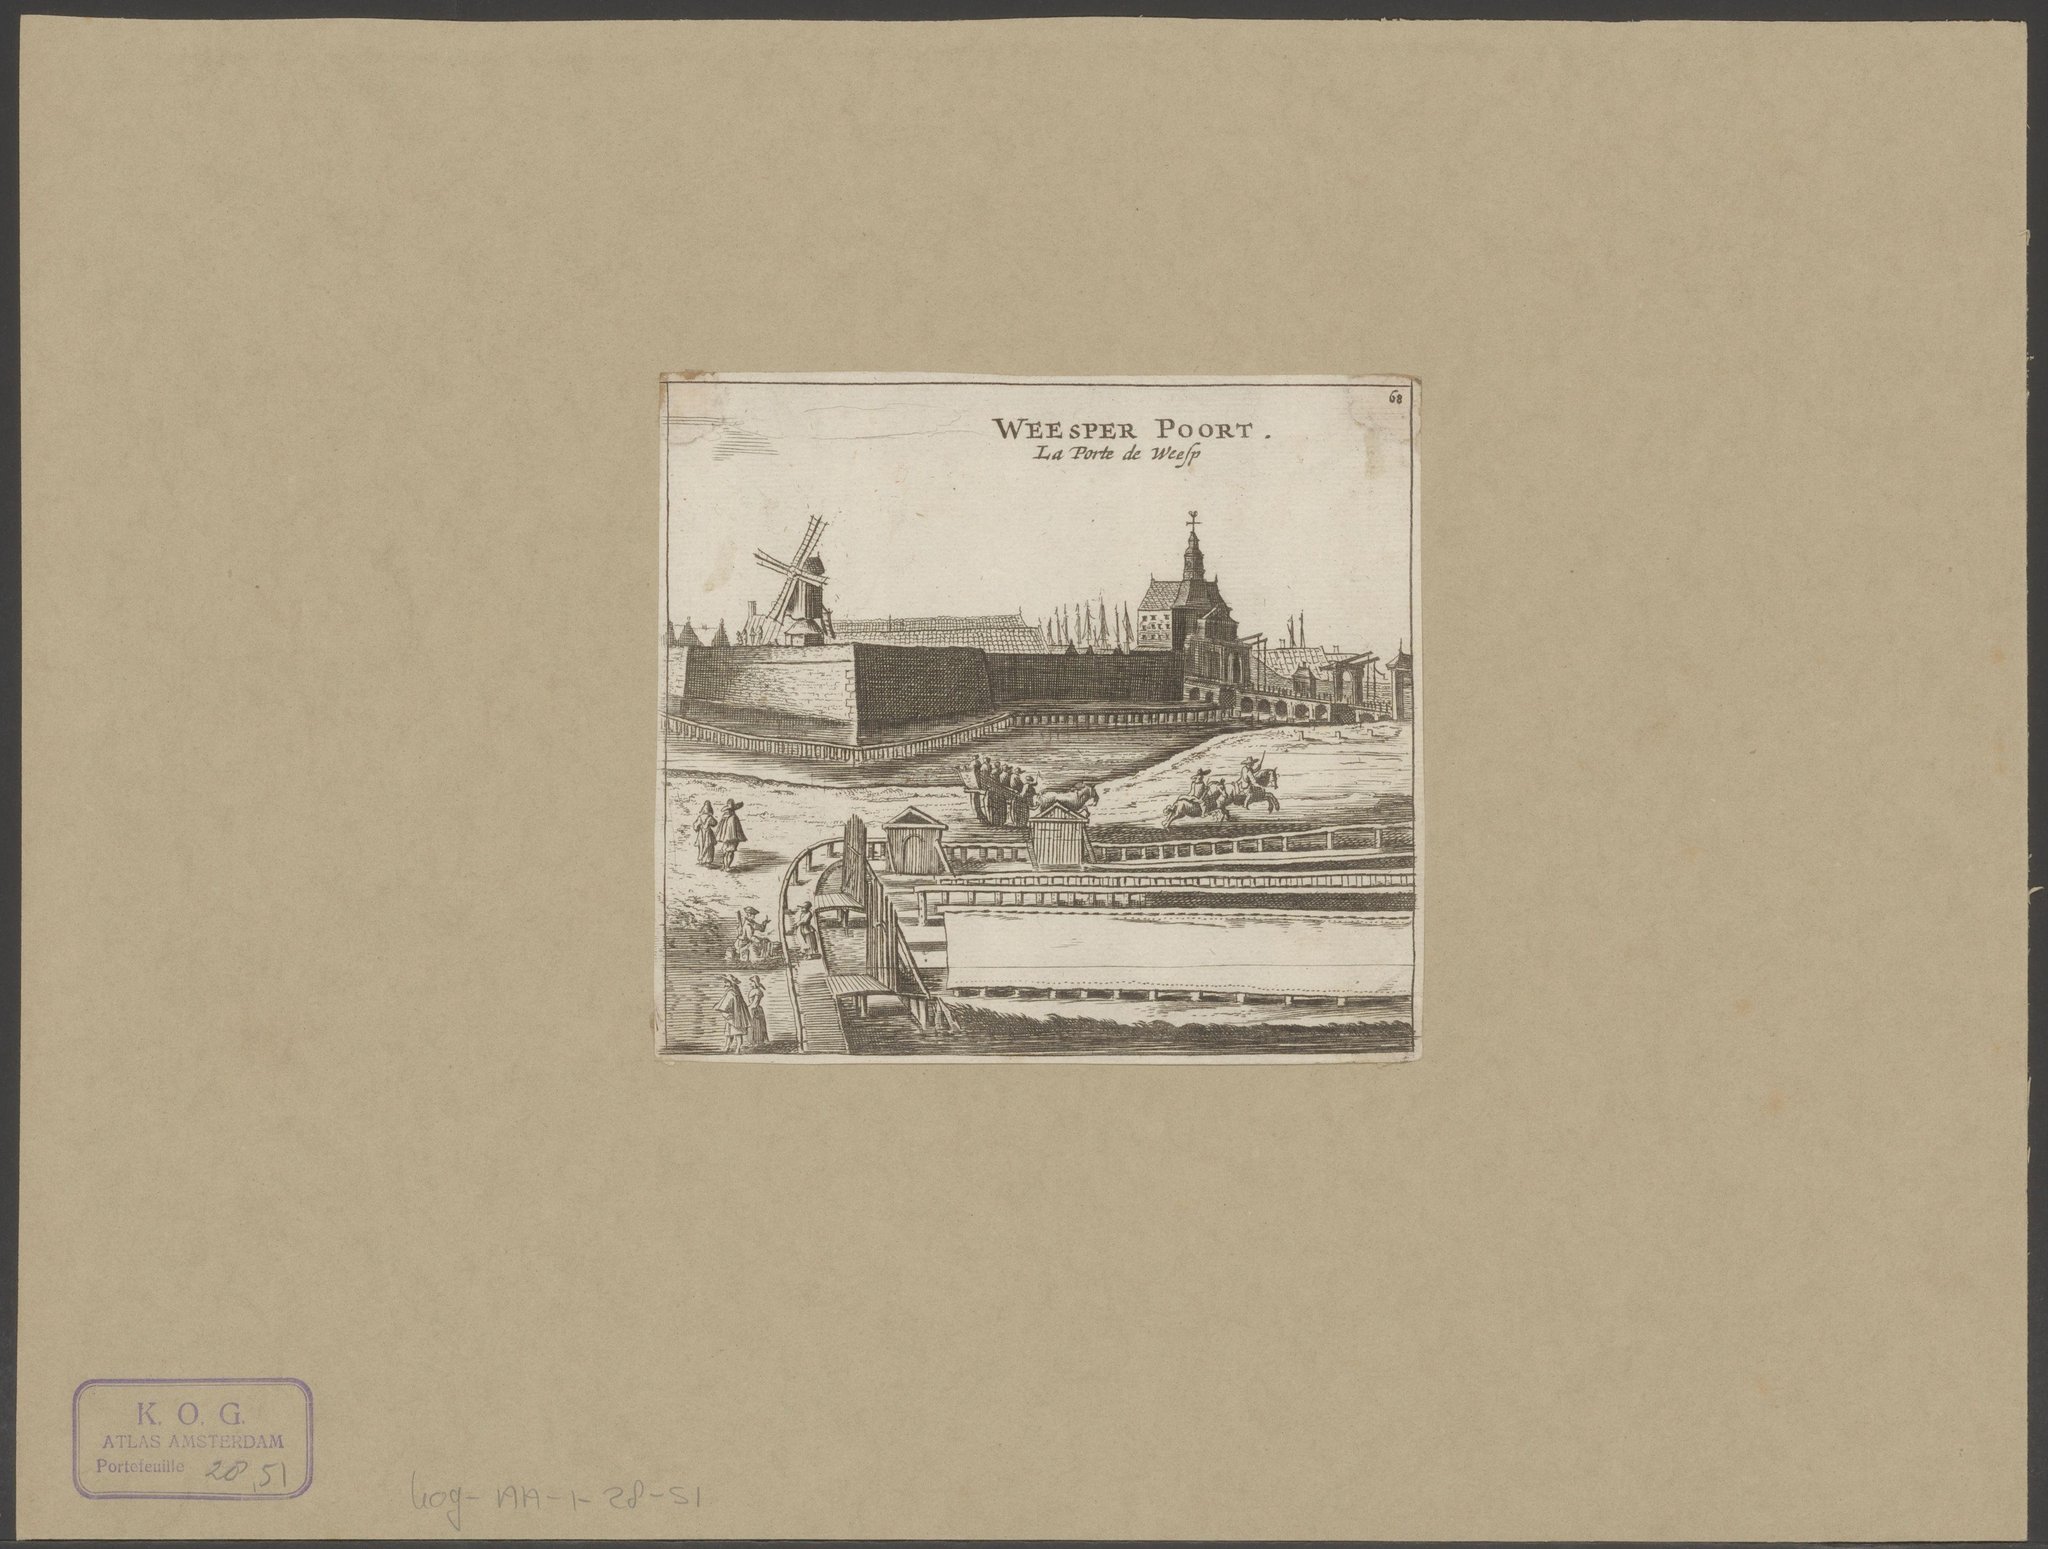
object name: print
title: Weesper Poort / La Porte de Weesp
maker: Anonymous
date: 1680-1749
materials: paper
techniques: etching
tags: city-gate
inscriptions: collector's mark: Lugt 1641b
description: Prent waarschijnlijk uit: Alle de voornaamste Gebouwen der wiitvermaarde Koopstad Amsterdam (...). Amsterdam: Hieronymus Sweerts, Jan Bouman en Aart Oossaan, [1680]. Of uit: Beknopte beschryving van alle de voornaamste gebouwen der wydvermaarde koopstad Amsterdam. Amsterdam: Jan Roman (II), 1741. Of uit: Beknopte beschrijving Van alle de voornaamste Gebouwen der Wydvermaard Koopstad Amsterdam (...). Amsterdam: Jan van der Heyde, 1749. Eerdere staat gebruikt in: Beschryvinge van Amsterdam, Haar eerste oorspronk uyt den Huyze der Heeren van Aemstel en Aemstellant (...). Amsterdam: Marcus Willemsz. Doornick, 1665.